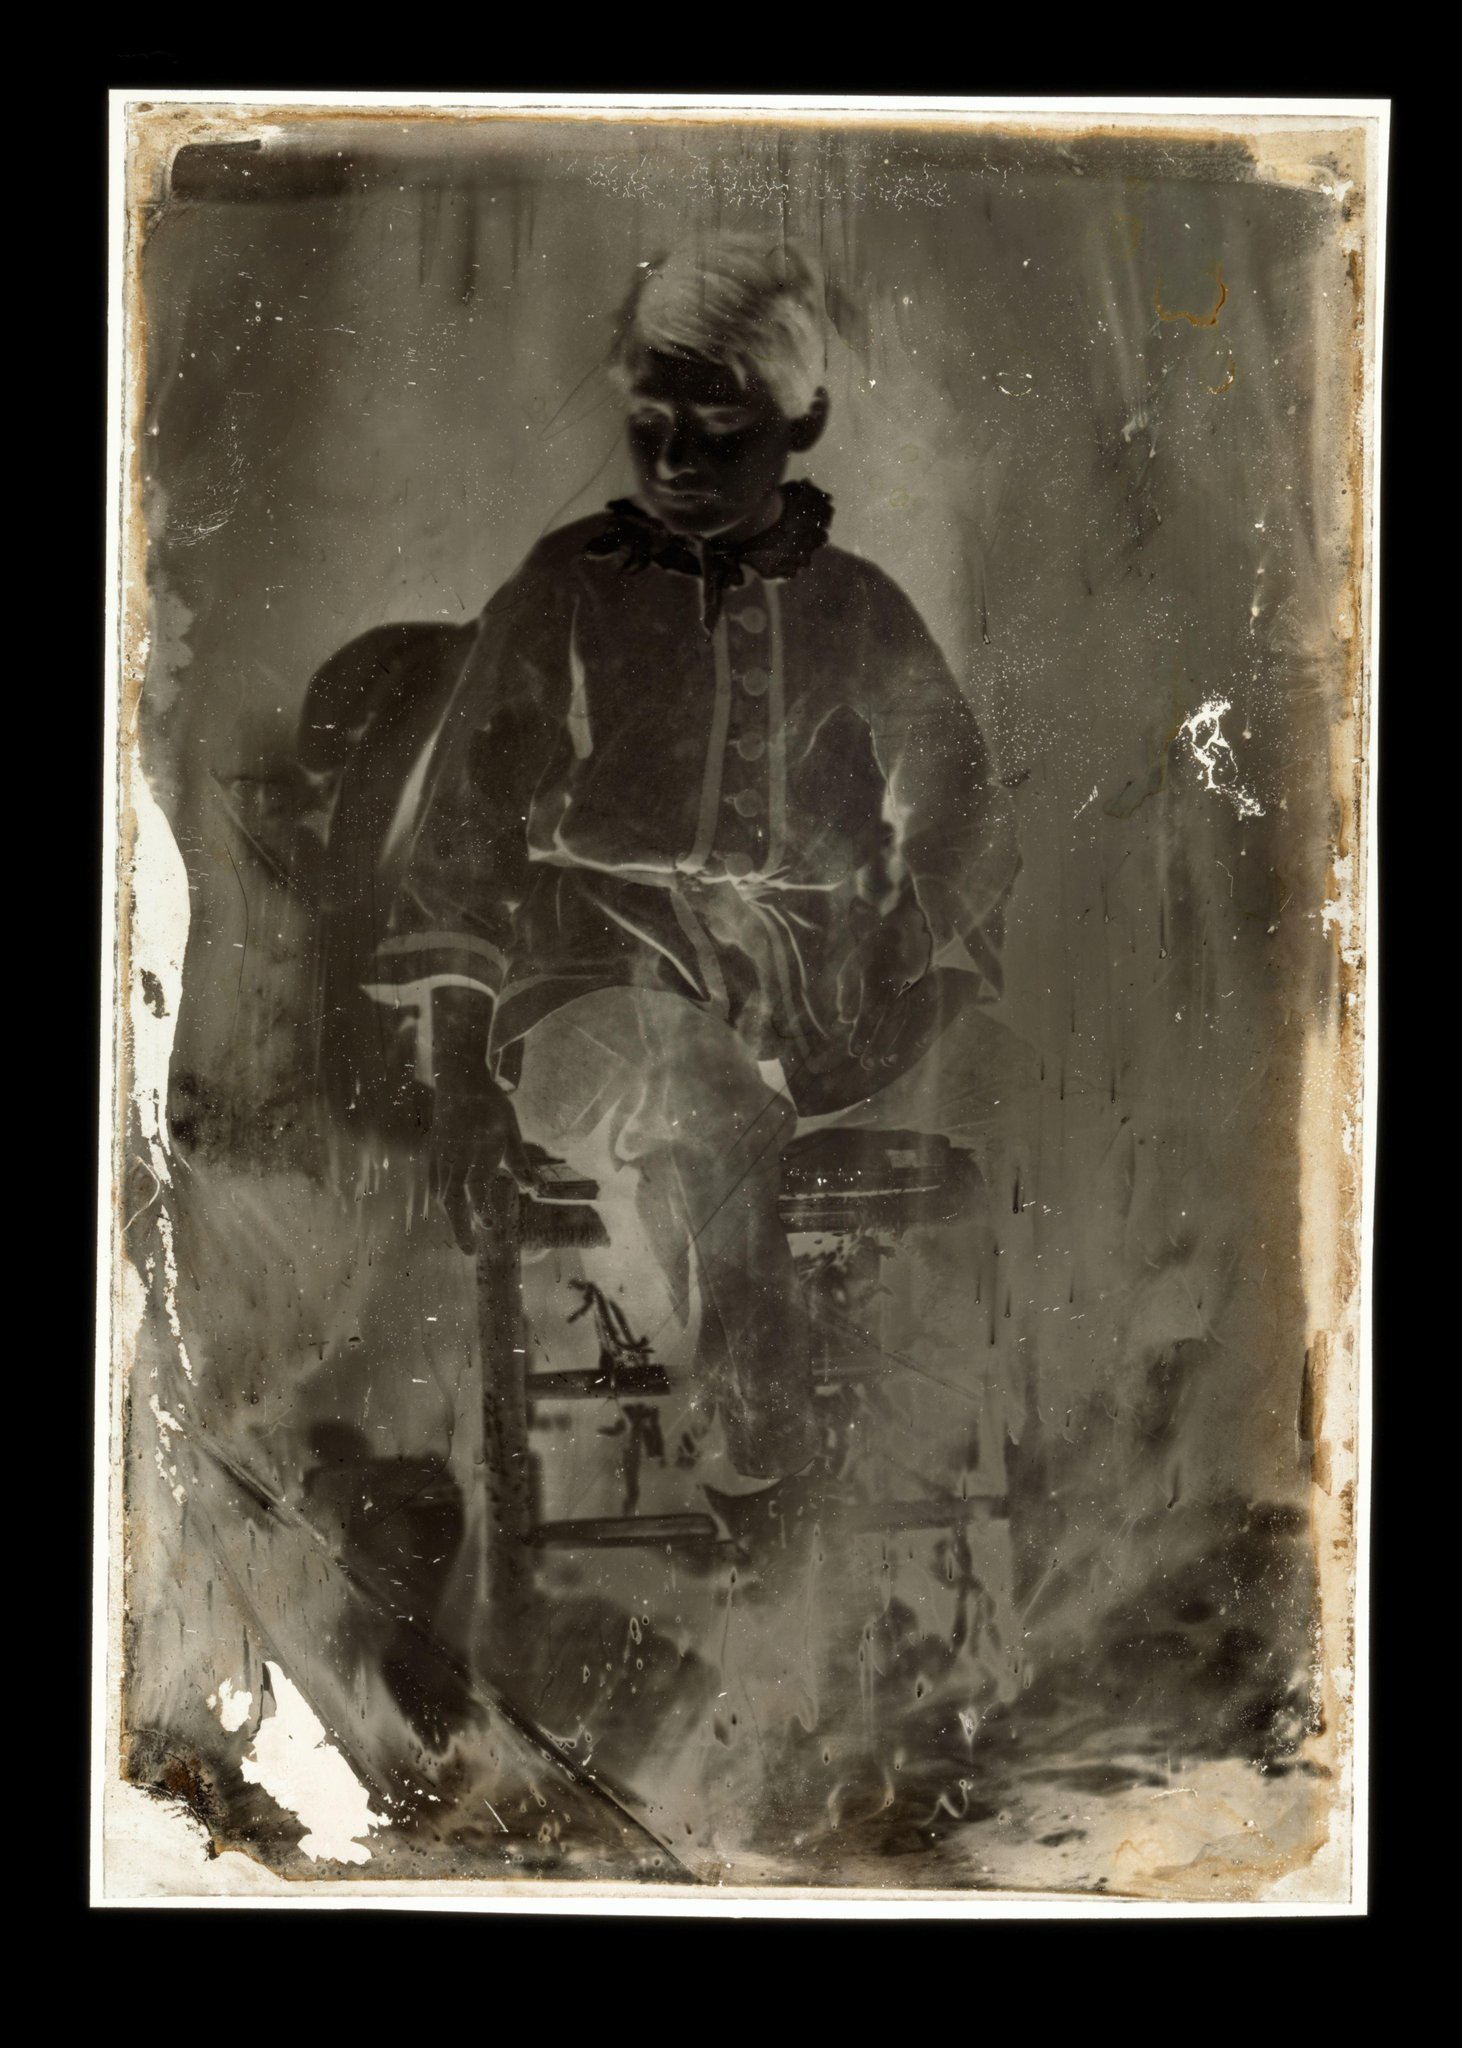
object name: glasnegatief, glasplaatnegatief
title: Groep glasnegatieven uit de nalatenschap van de schilder Laurens Lodewijk Kleijn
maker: laurens lodewijk kleijn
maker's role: draughtsman, painter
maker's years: 1826-1909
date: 1865-1900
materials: glass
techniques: collodion process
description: Groep glasnegatieven uit de nalatenschap van de schilder Laurens Lodewijk Kleijn, stillevens, portretten, zelfportretten en kunstreproducties.